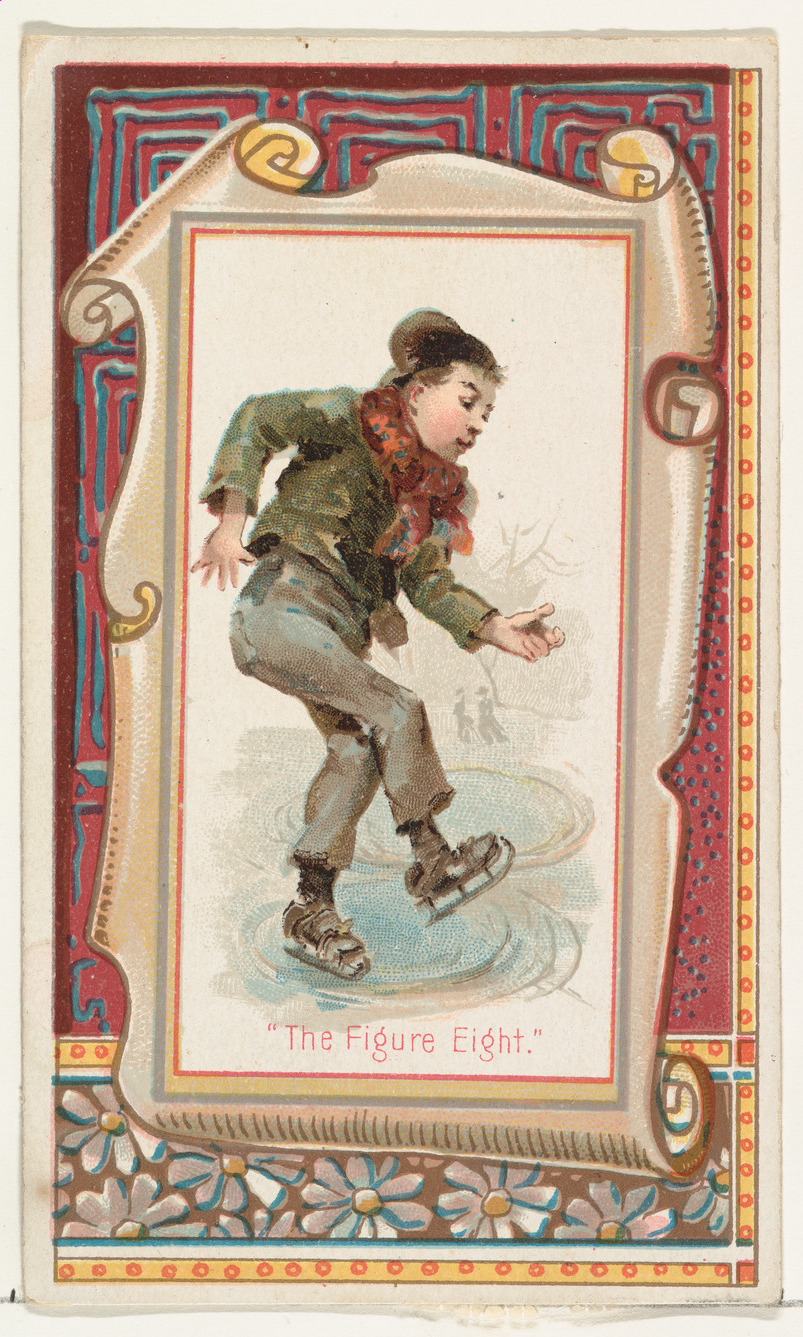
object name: print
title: "The Figure Eight," from the Terrors of America set (N136) issued by Duke Sons & Co. to promote Honest Long Cut Tobacco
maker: w. duke, sons & co.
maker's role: publisher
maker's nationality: american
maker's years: 1870-1920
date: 1888-1889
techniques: color lithograph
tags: boys